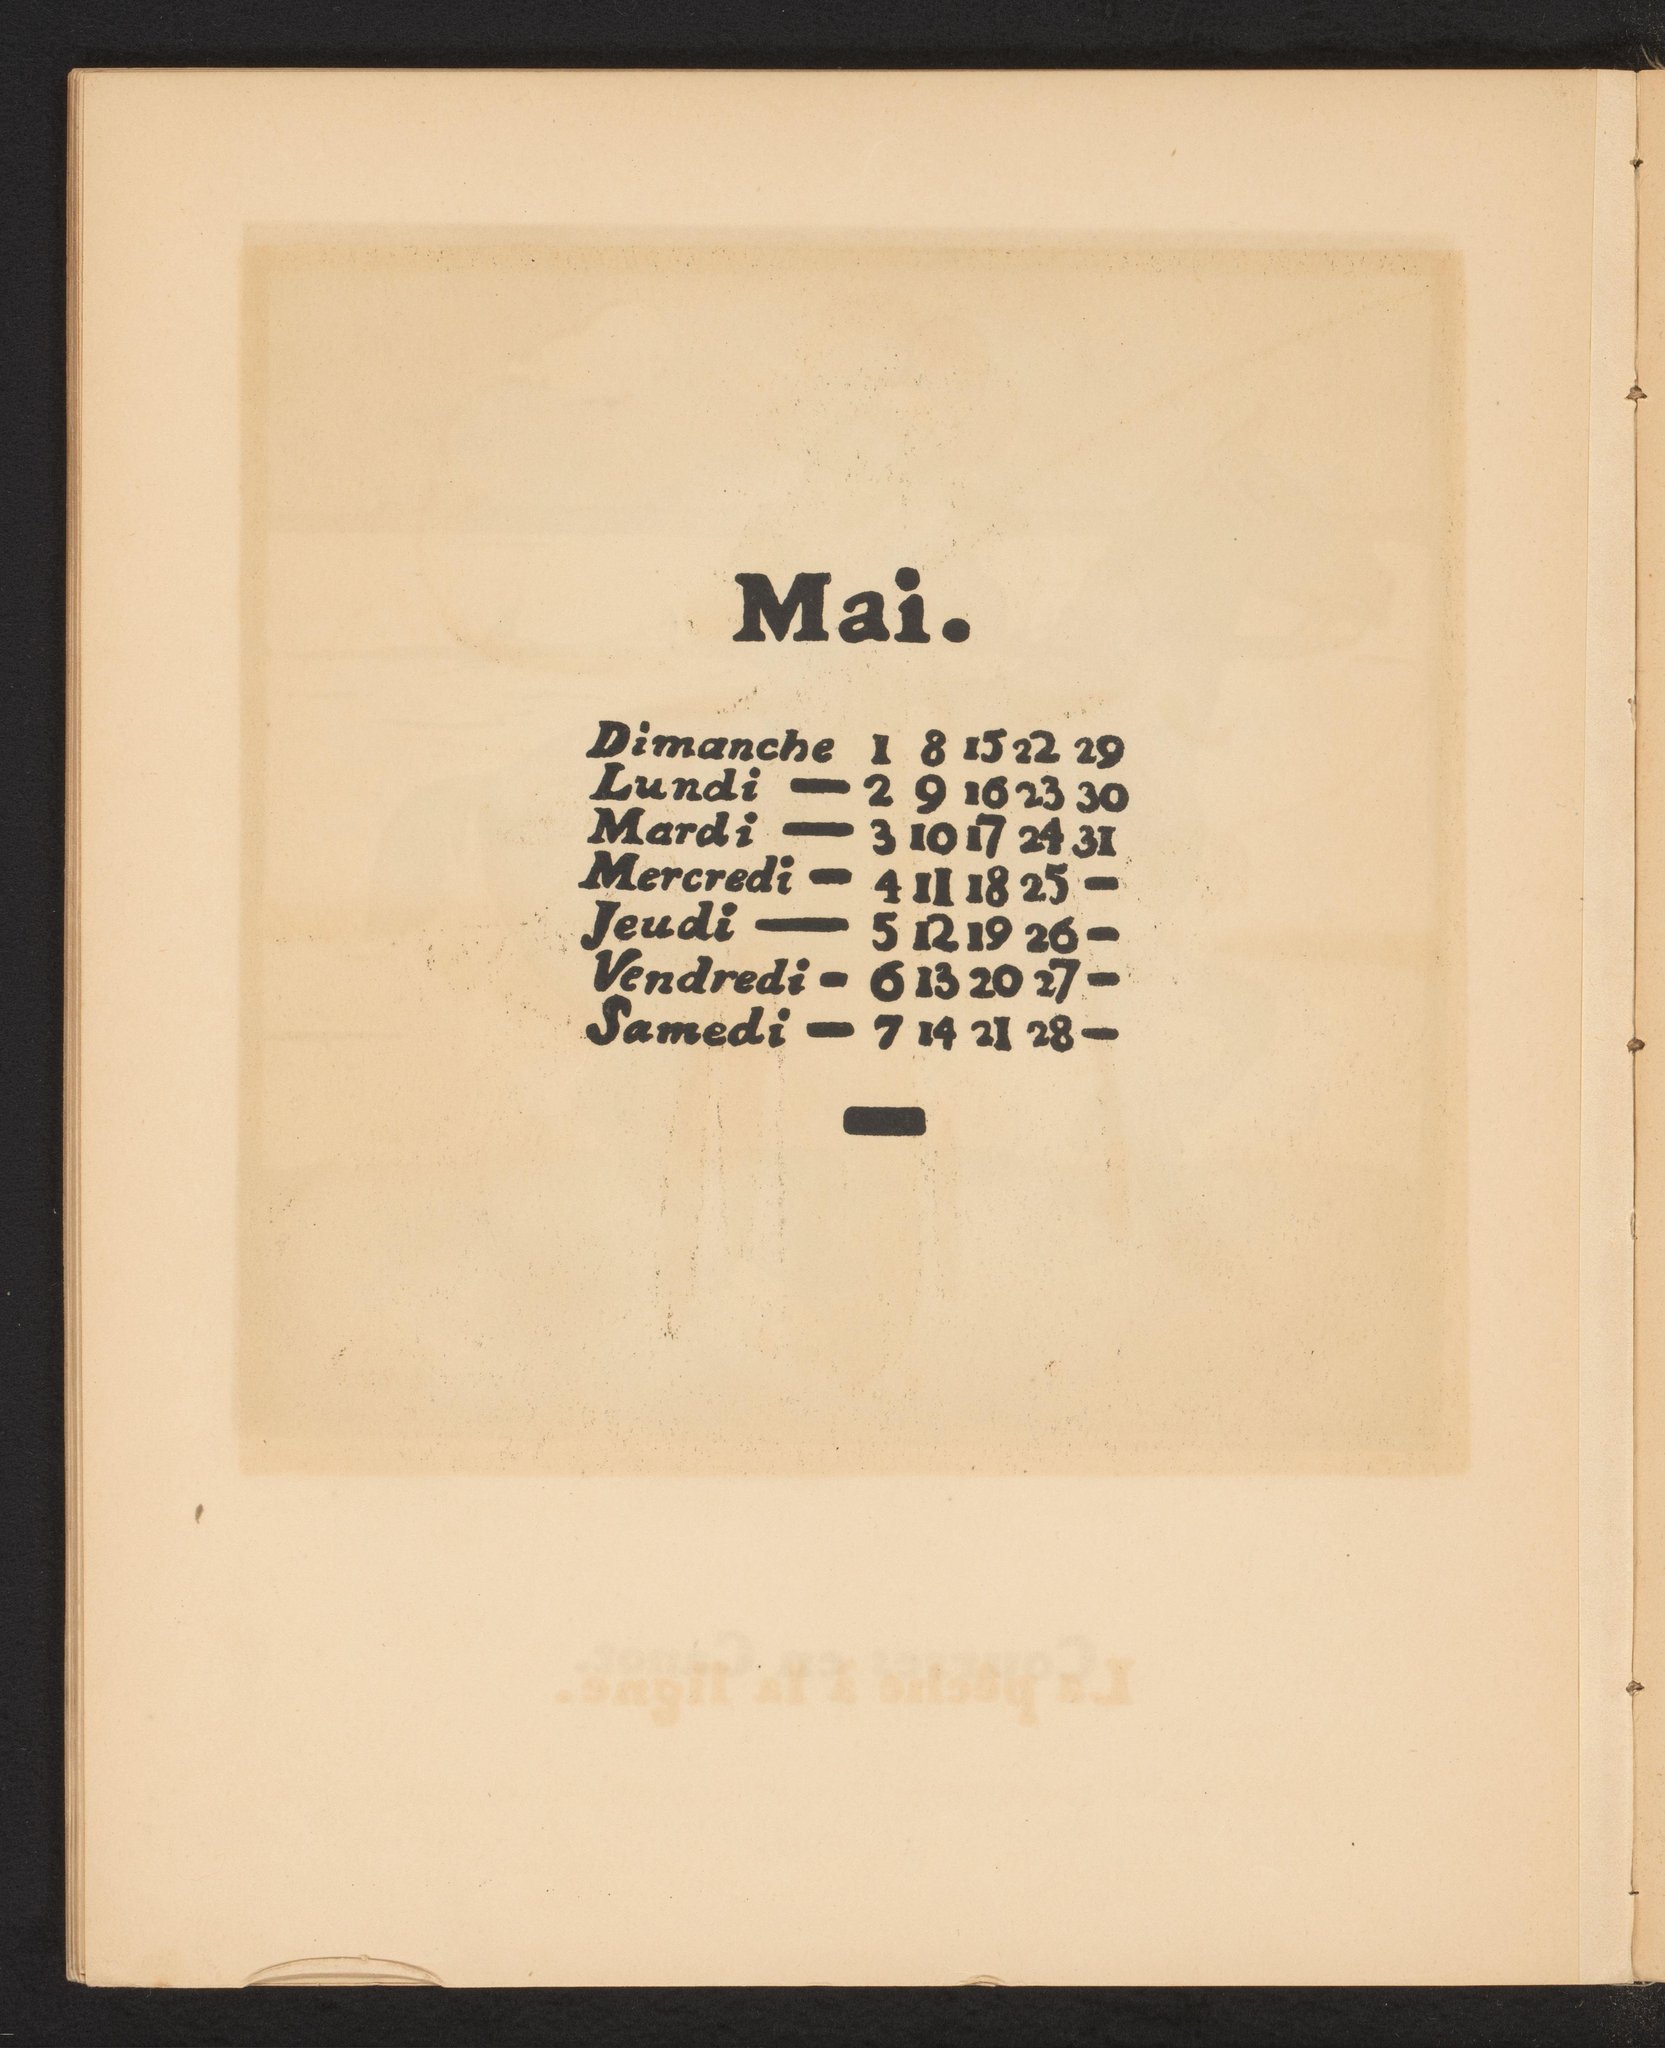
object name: calendar leaf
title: Almanach de douze Sports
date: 1898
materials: paper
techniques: lithograph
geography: paris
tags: may ~ other concepts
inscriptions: : ‘Mai./ Dimanche 1 8 15 22 29/ Lundi - 2 9 16 (...)’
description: Kalendermaand bij de illustratie op het tegenoverliggende blad. Prent maakt deel uit van een boek.